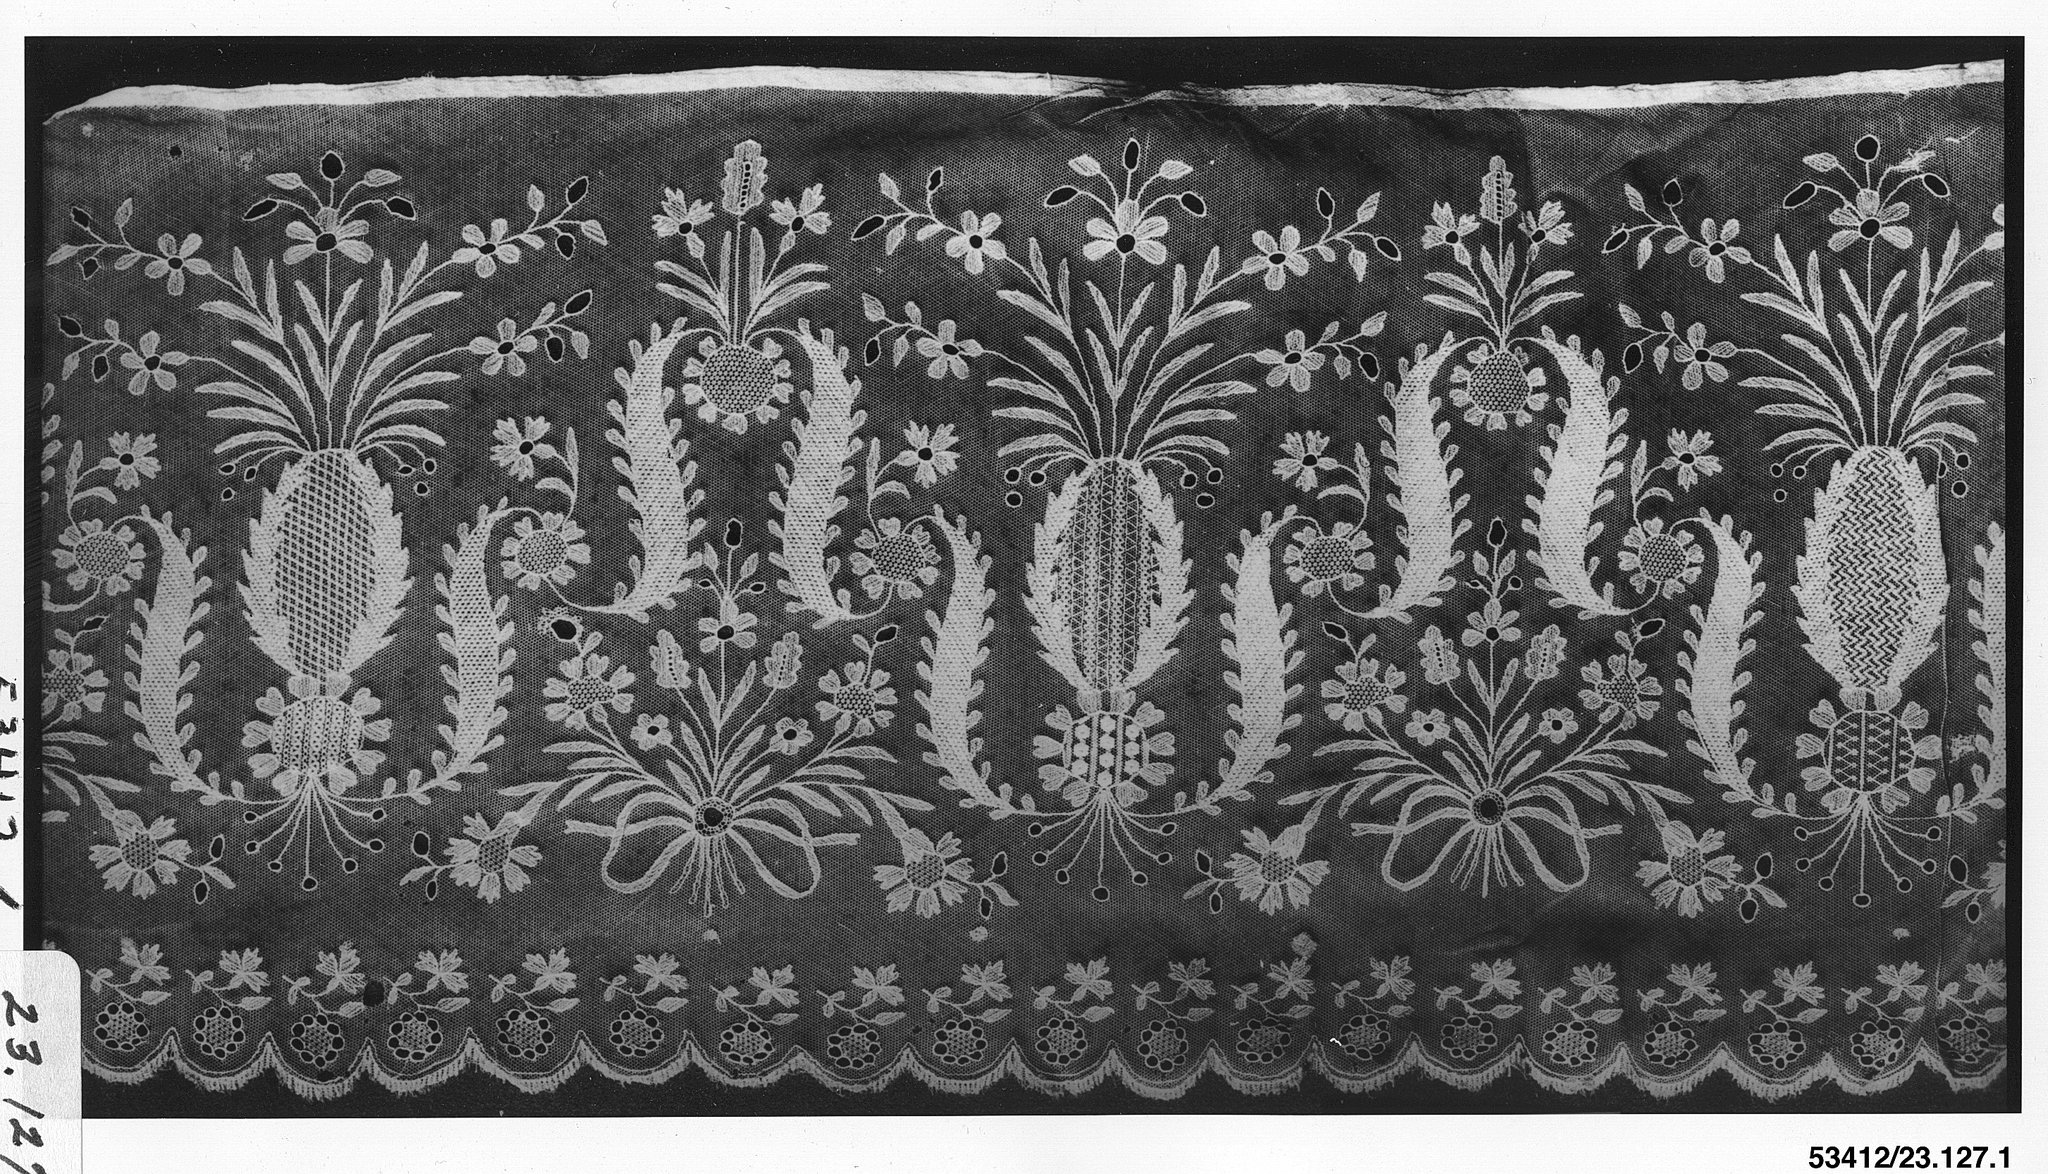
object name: border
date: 1801-1833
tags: flowers